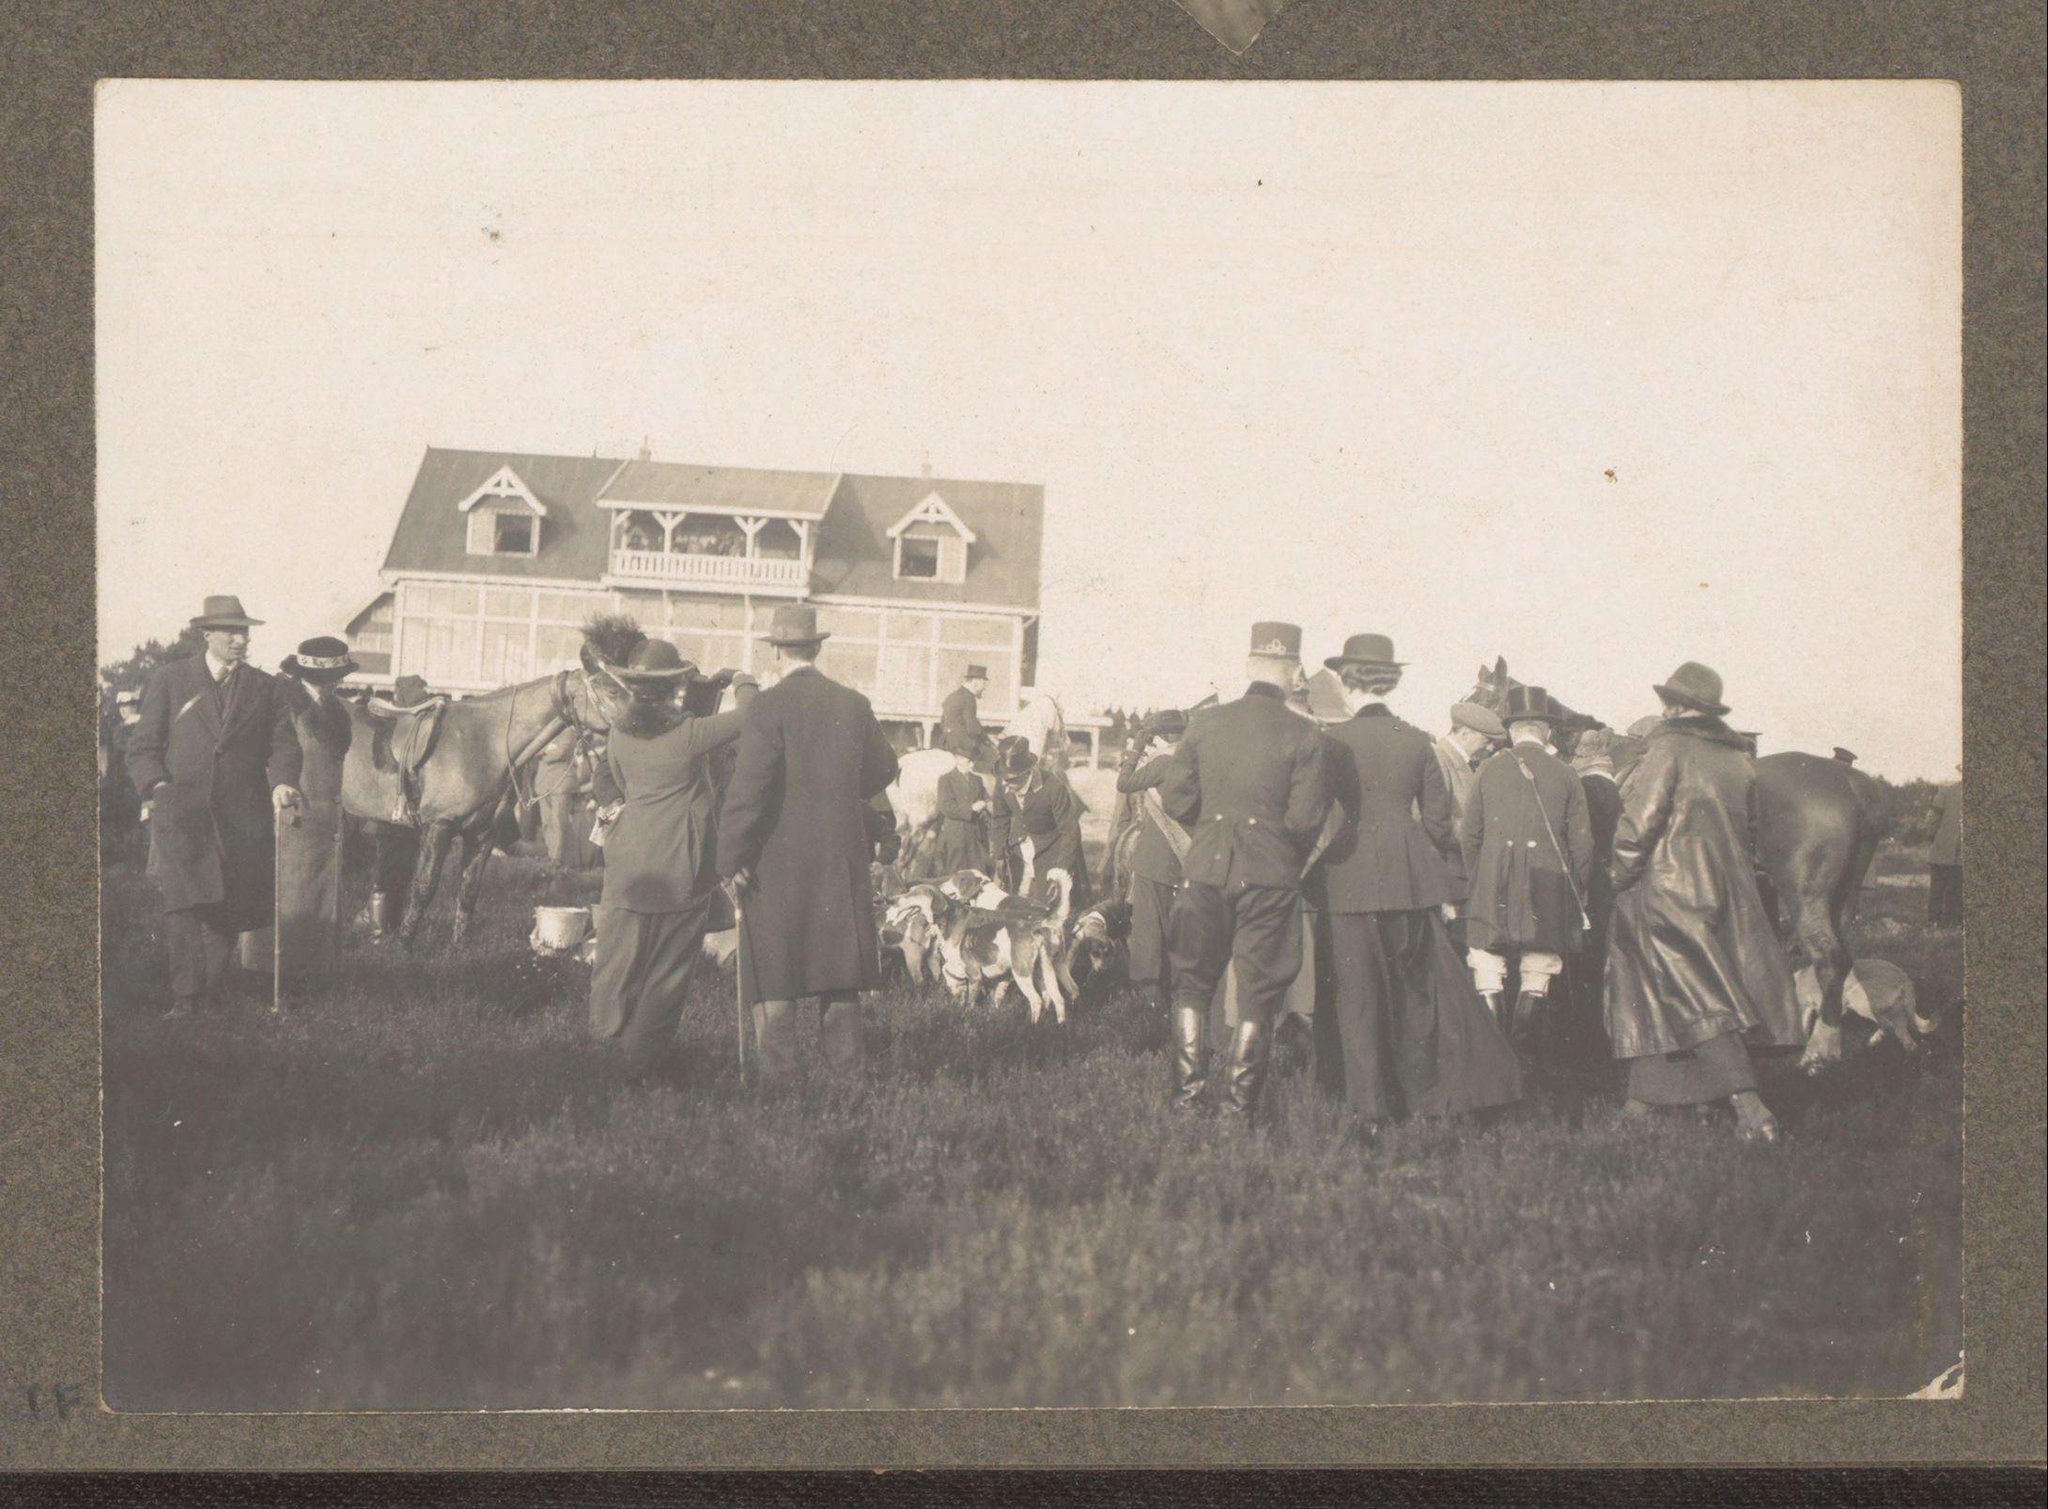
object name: photograph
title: Ruitertafereel op Koninklijke Houtvesterij Het Loo: publiek, ruiters en een meute honden bij een huis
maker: Anonymous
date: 1900-1925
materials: photographic support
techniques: gelatin silver print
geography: het loo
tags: hunting, chase, hunting dogs, hunting-ground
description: Onderdeel van Fotoalbum van de heer Brams, opperhoutvester van koningin Wilhelmina op Koninklijke Houtvesterij Het Loo.